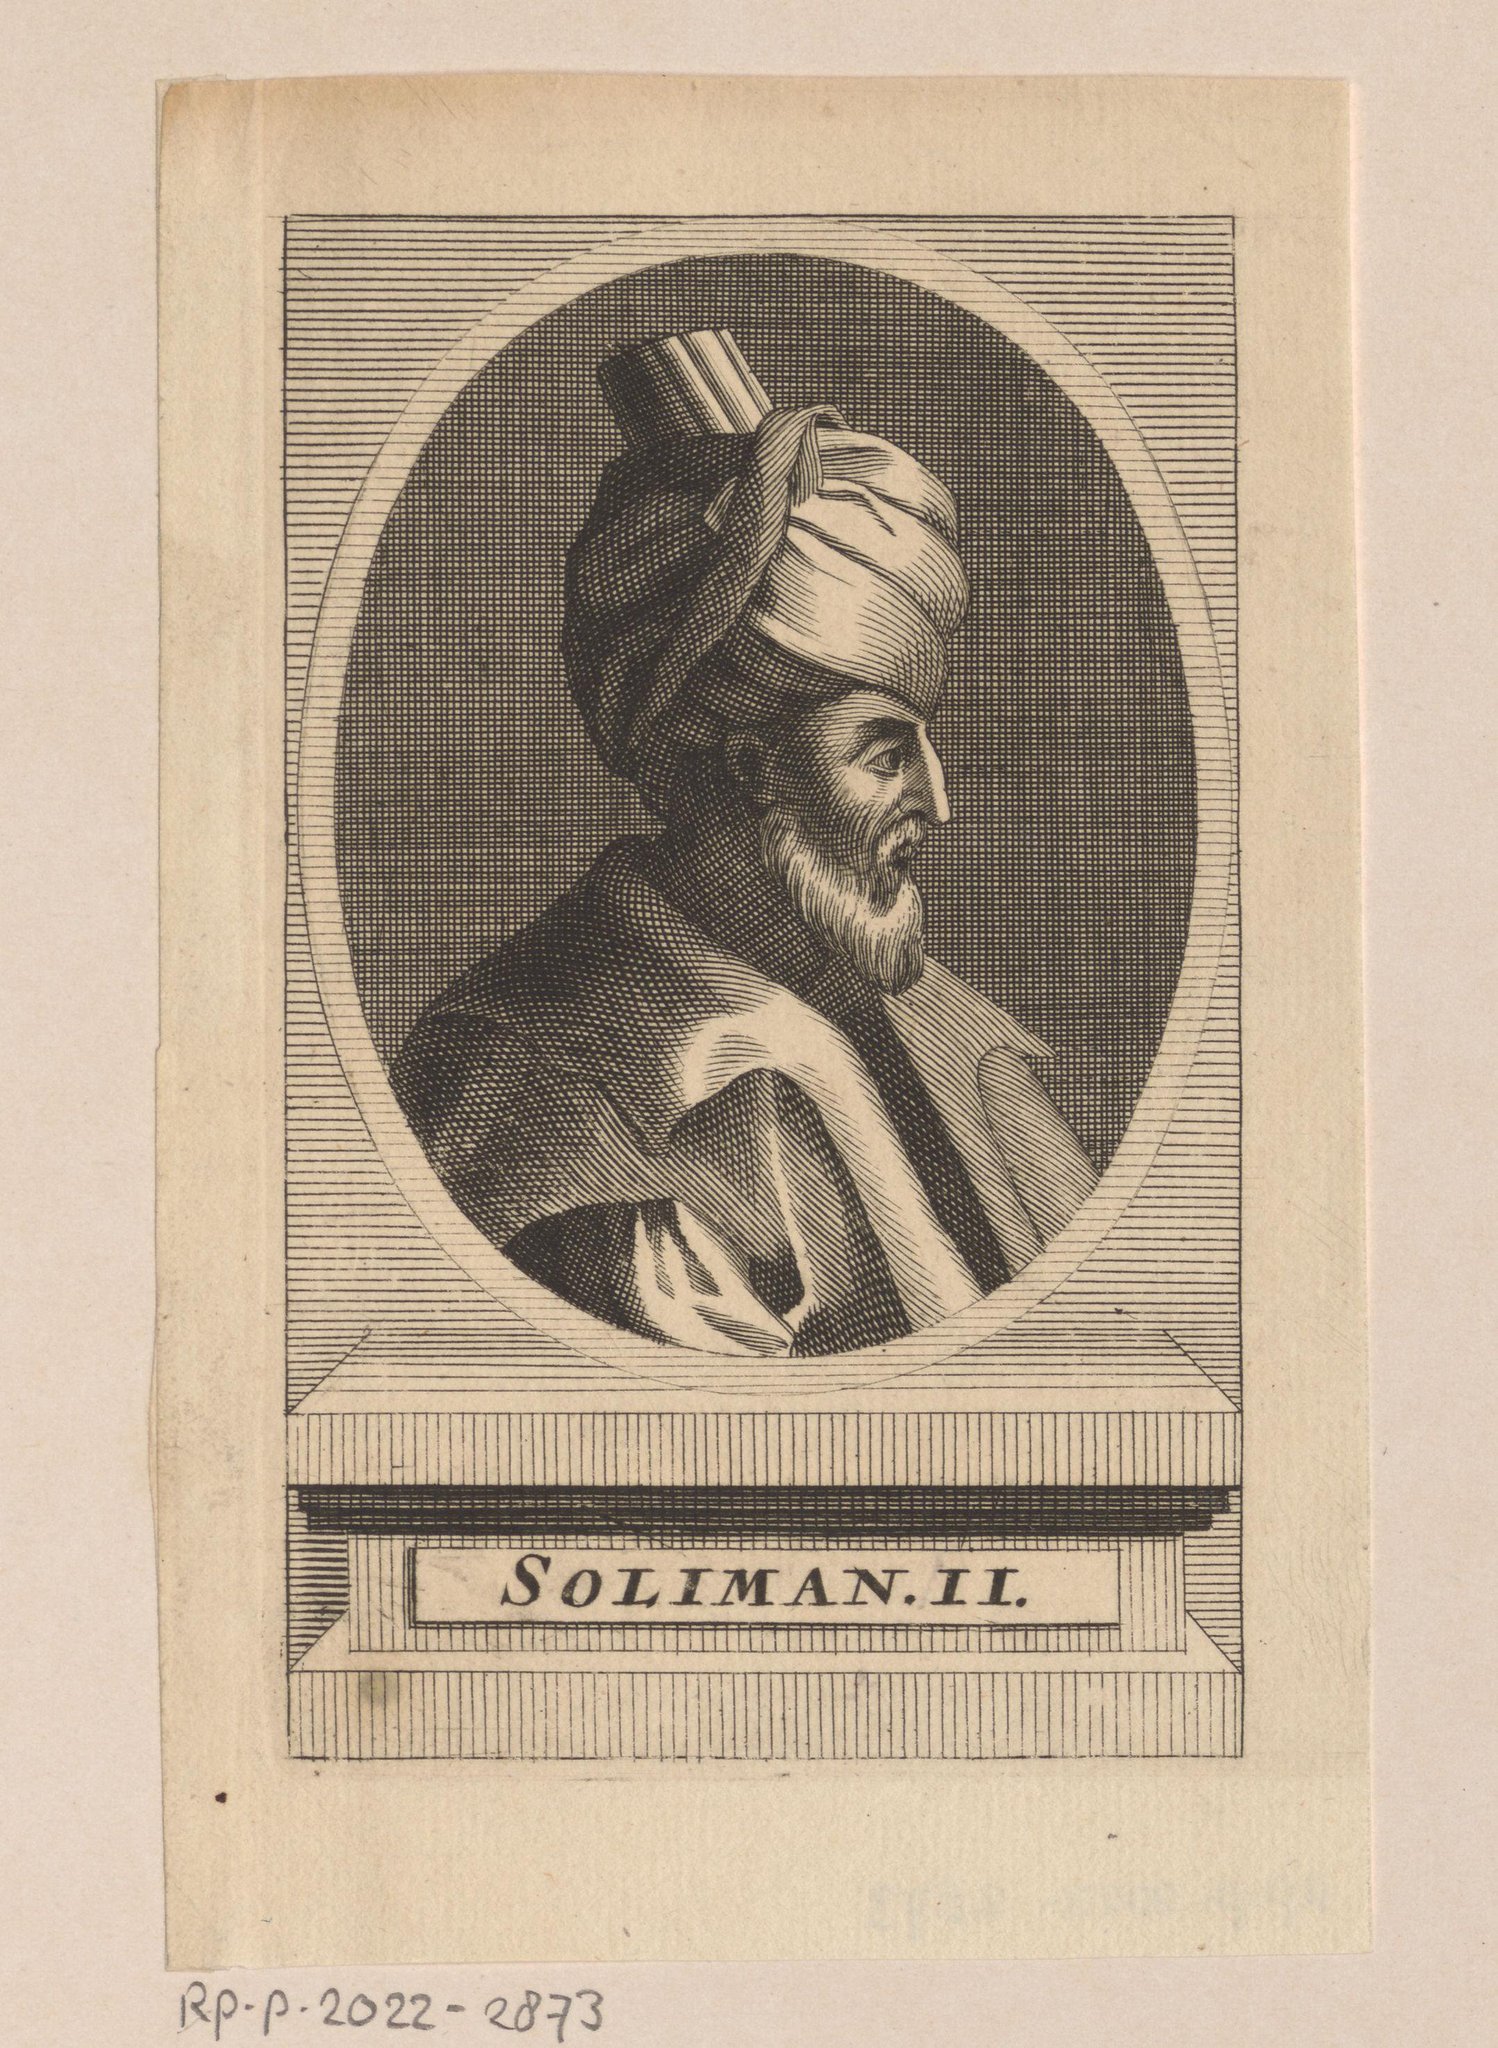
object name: print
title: Portret van Süleyman II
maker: Anonymous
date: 1687-1799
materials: paper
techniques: engraving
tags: historical persons, other sovereign (with title)